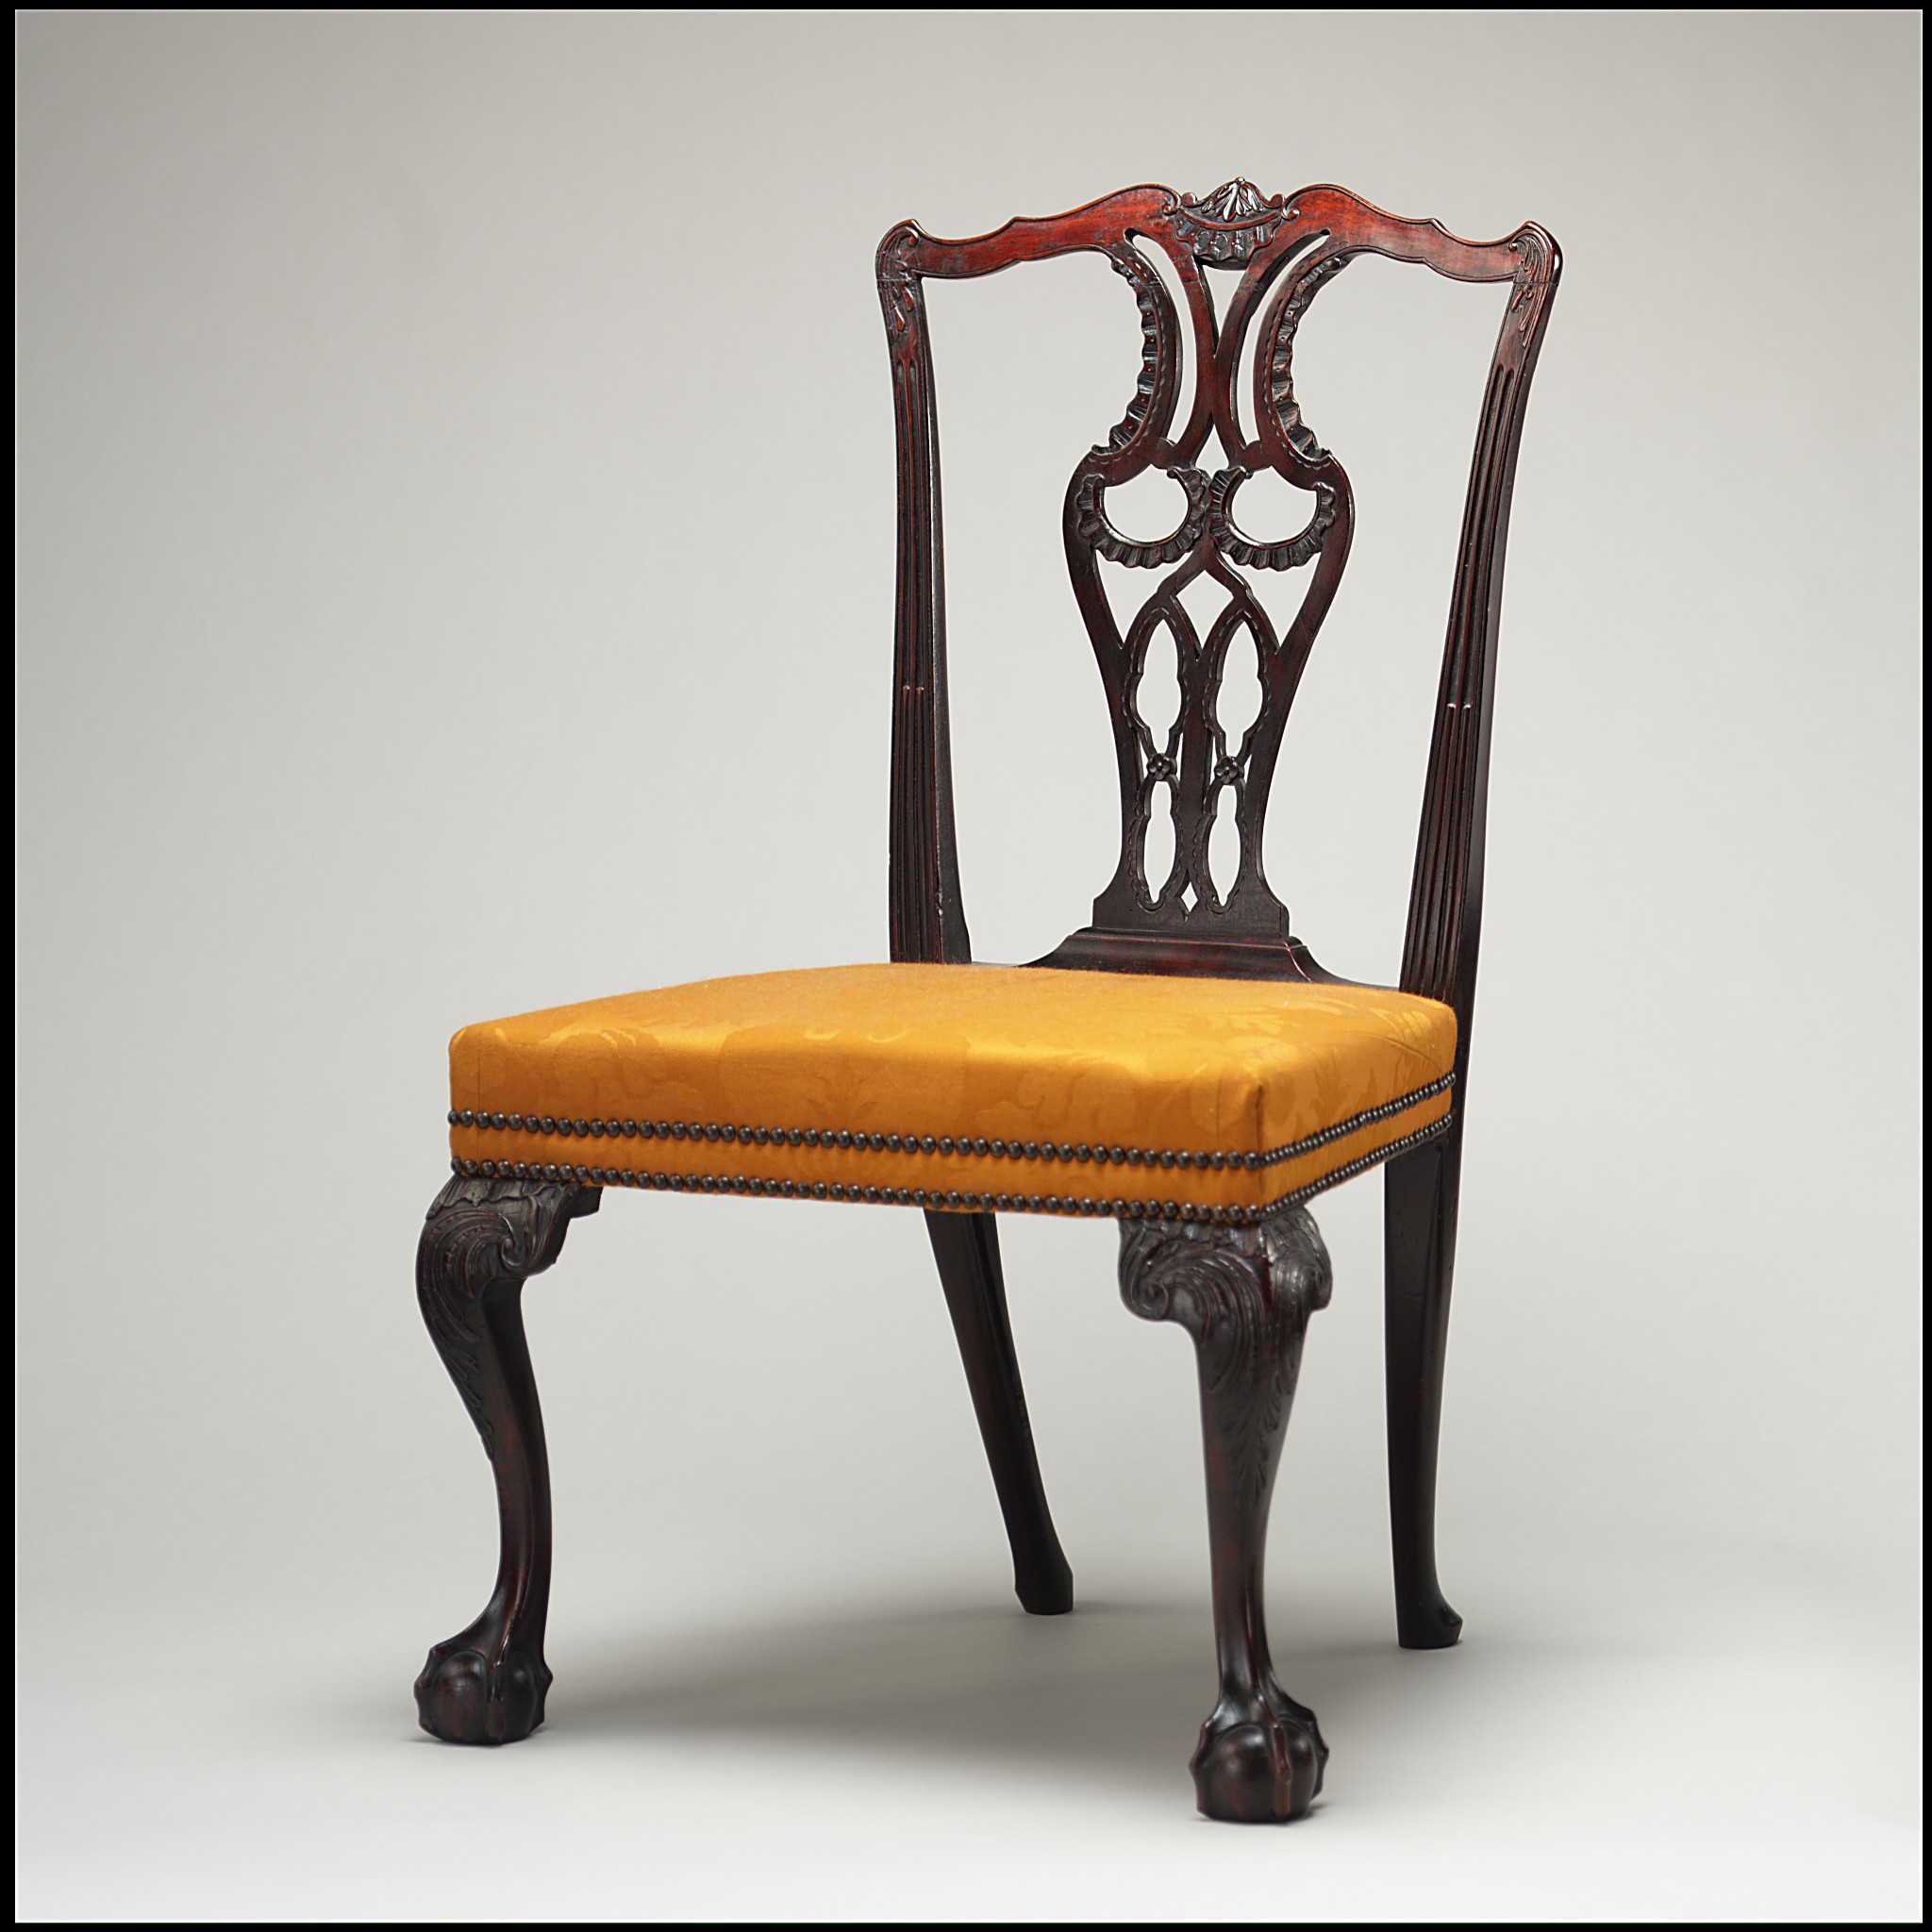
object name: side chair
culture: american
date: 1770-1790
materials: wood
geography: united states